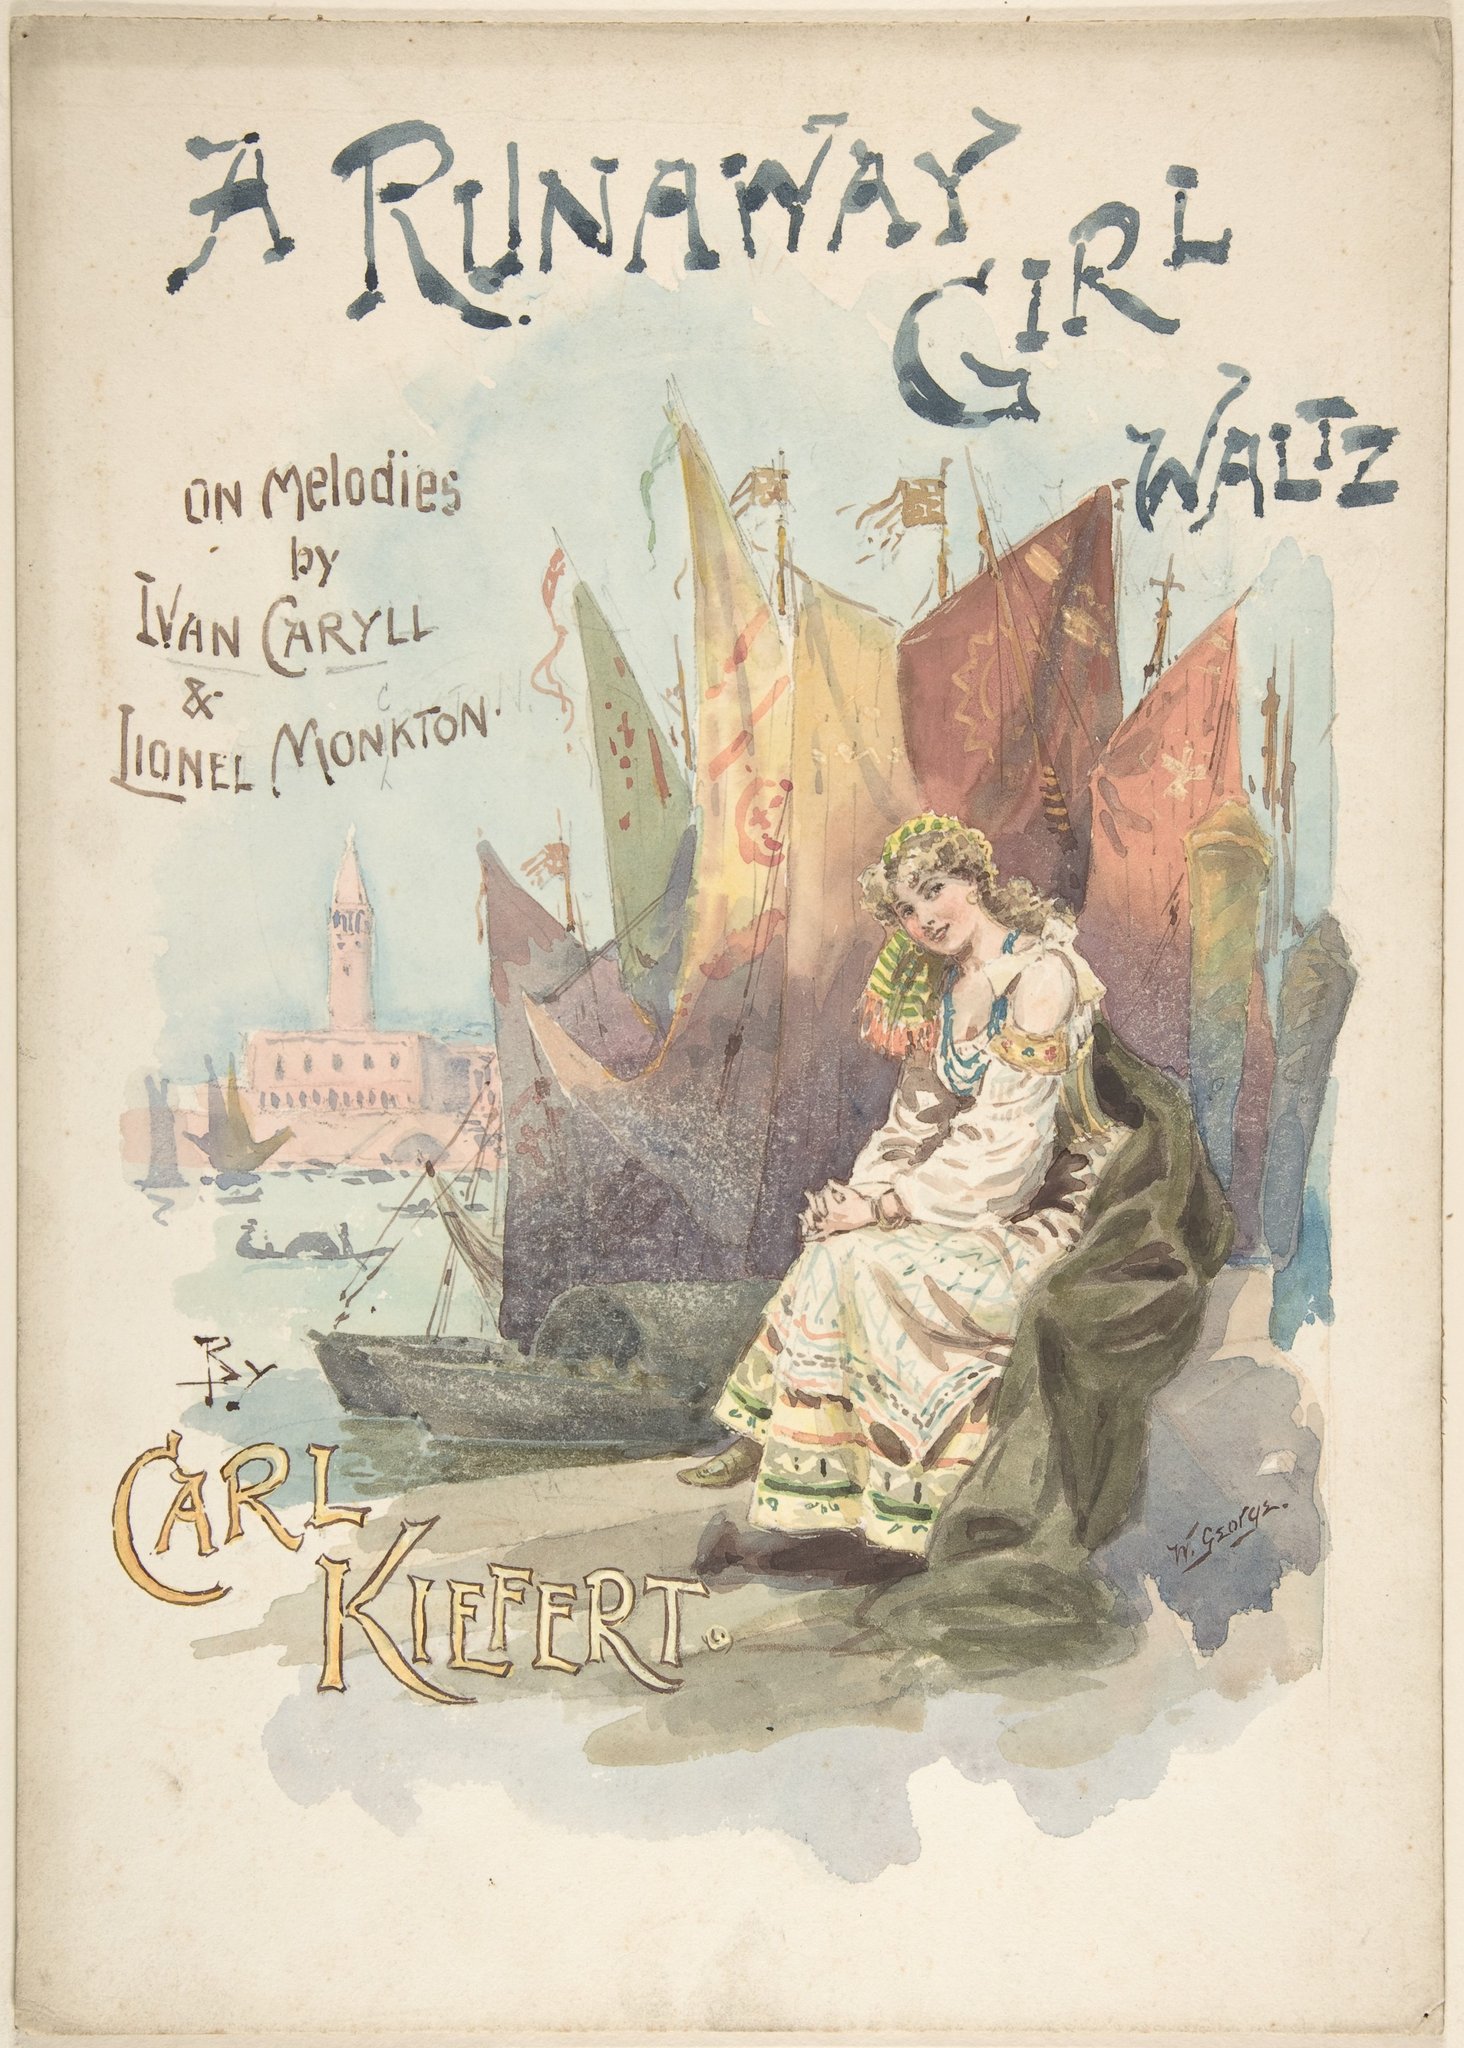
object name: drawing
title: Design for music cover: A Runaway Girl Waltz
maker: w. george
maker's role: artist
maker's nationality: british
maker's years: 1850-1900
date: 1898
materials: graphite, watercolor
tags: towers,girls,boats